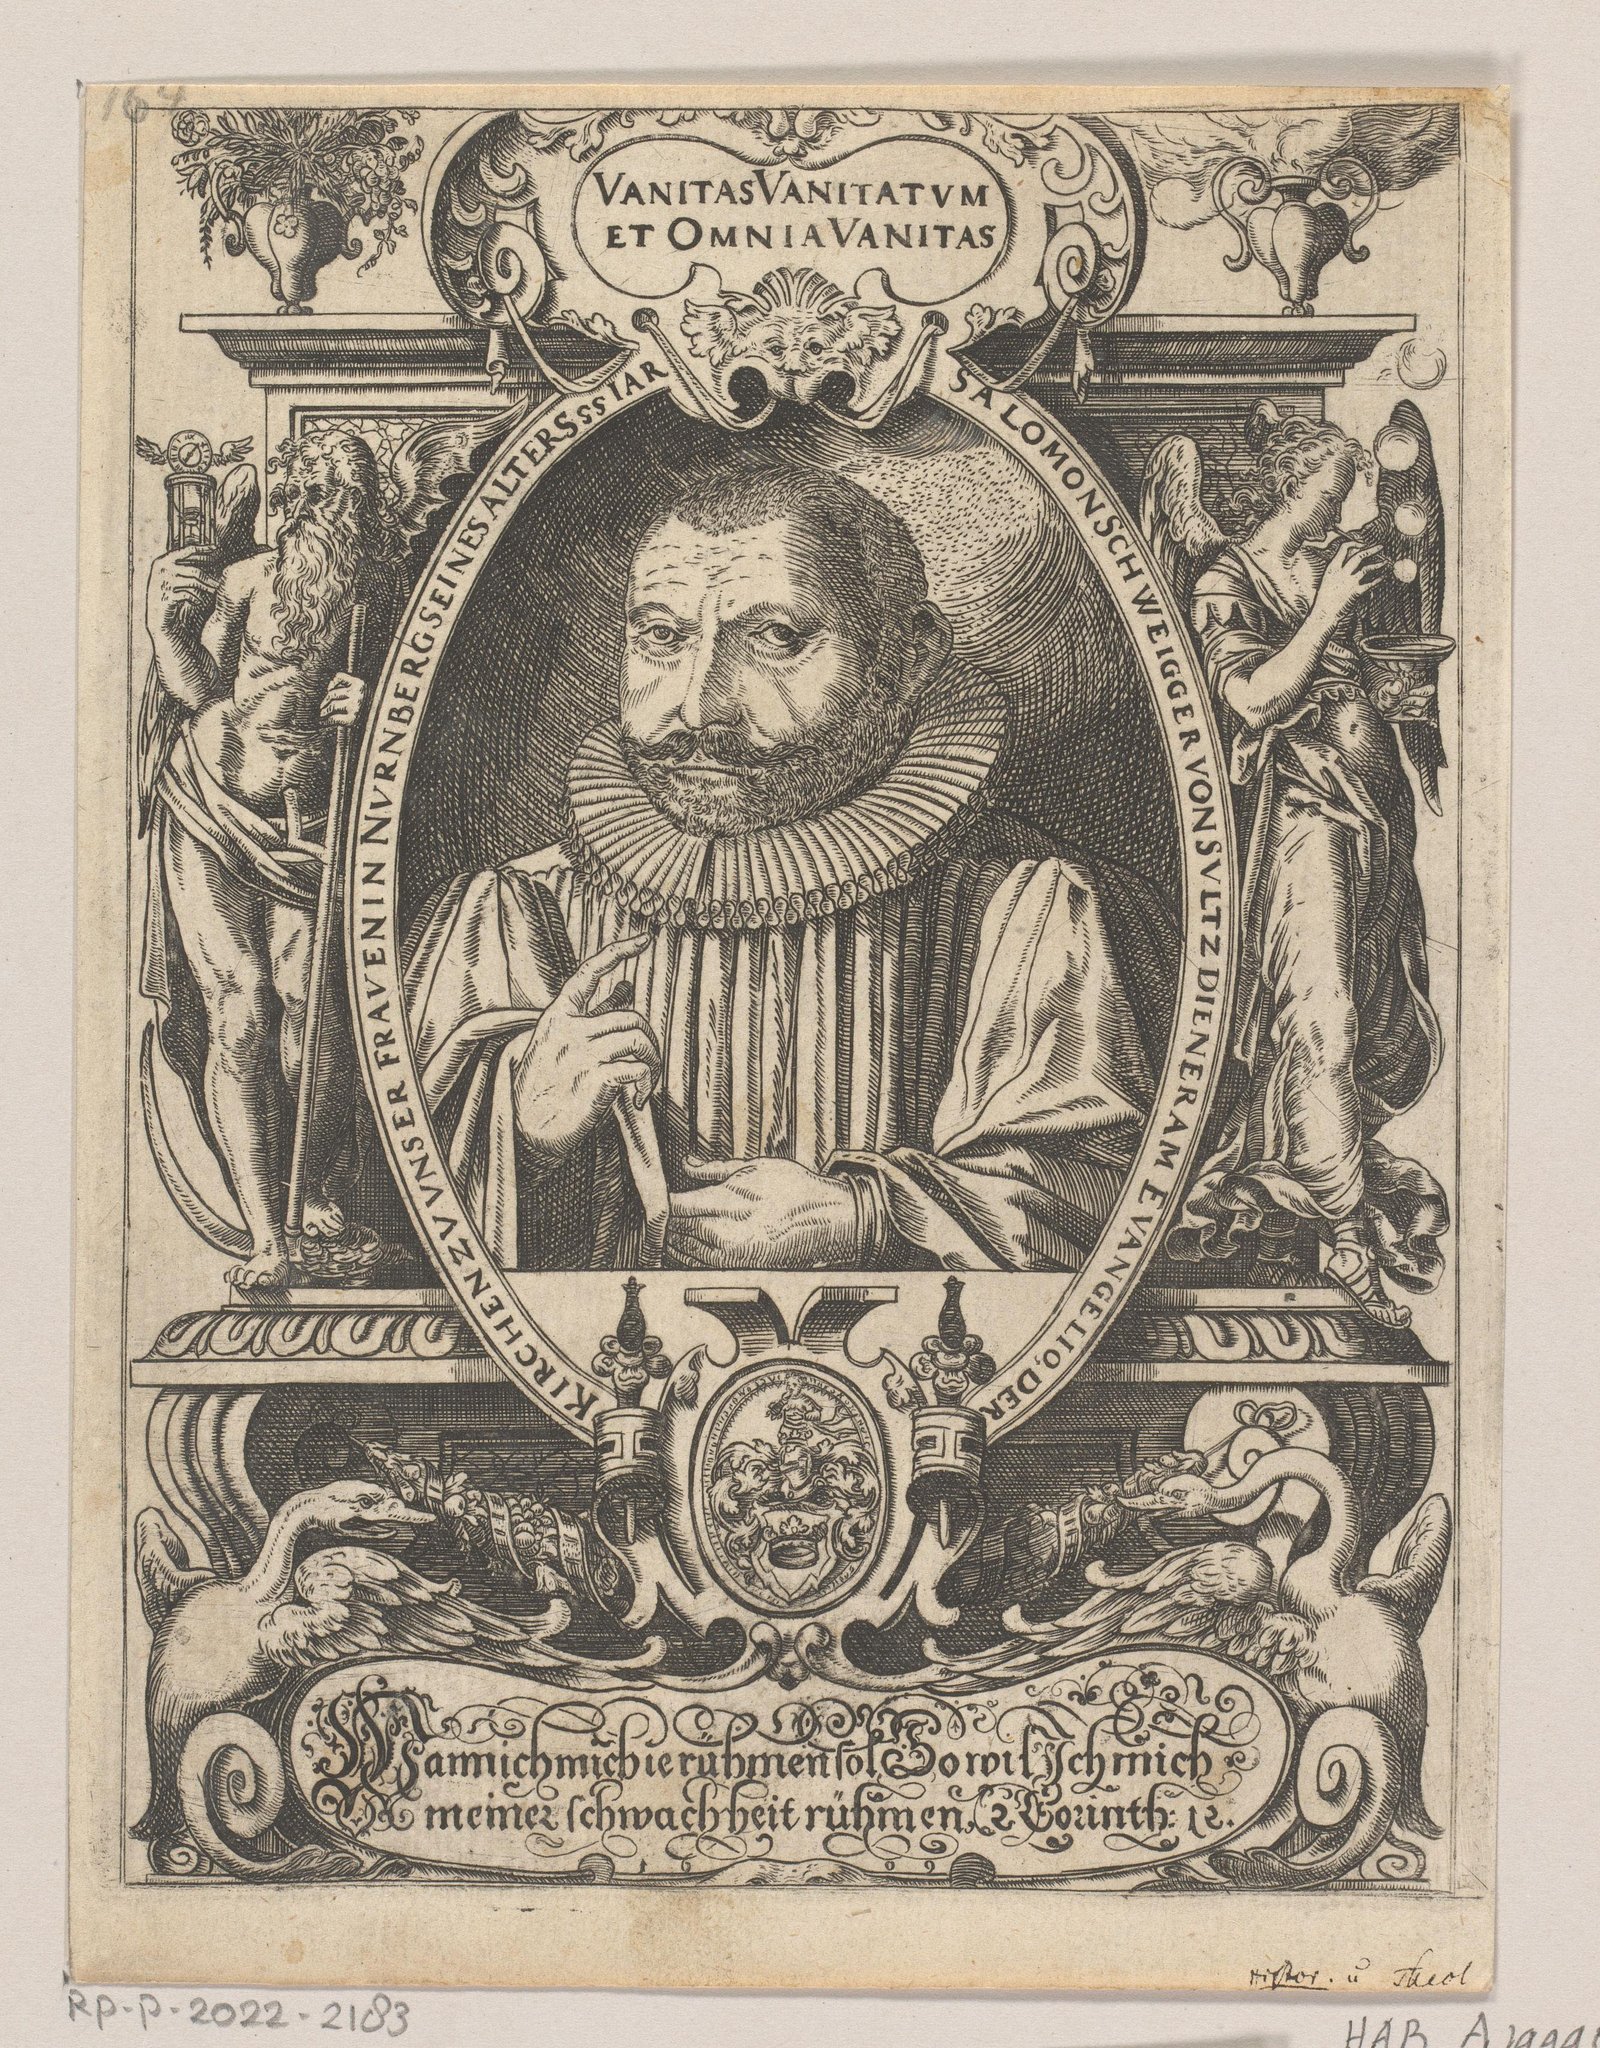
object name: print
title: Portret van Salomon Schweigger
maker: Anonymous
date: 1609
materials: paper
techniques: engraving, etching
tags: theologian, historical persons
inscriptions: inscription: ‘[...] u Theol’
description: Met tweeregelig onderschrift in het Duits en tekst in het Duits rondom het portret.